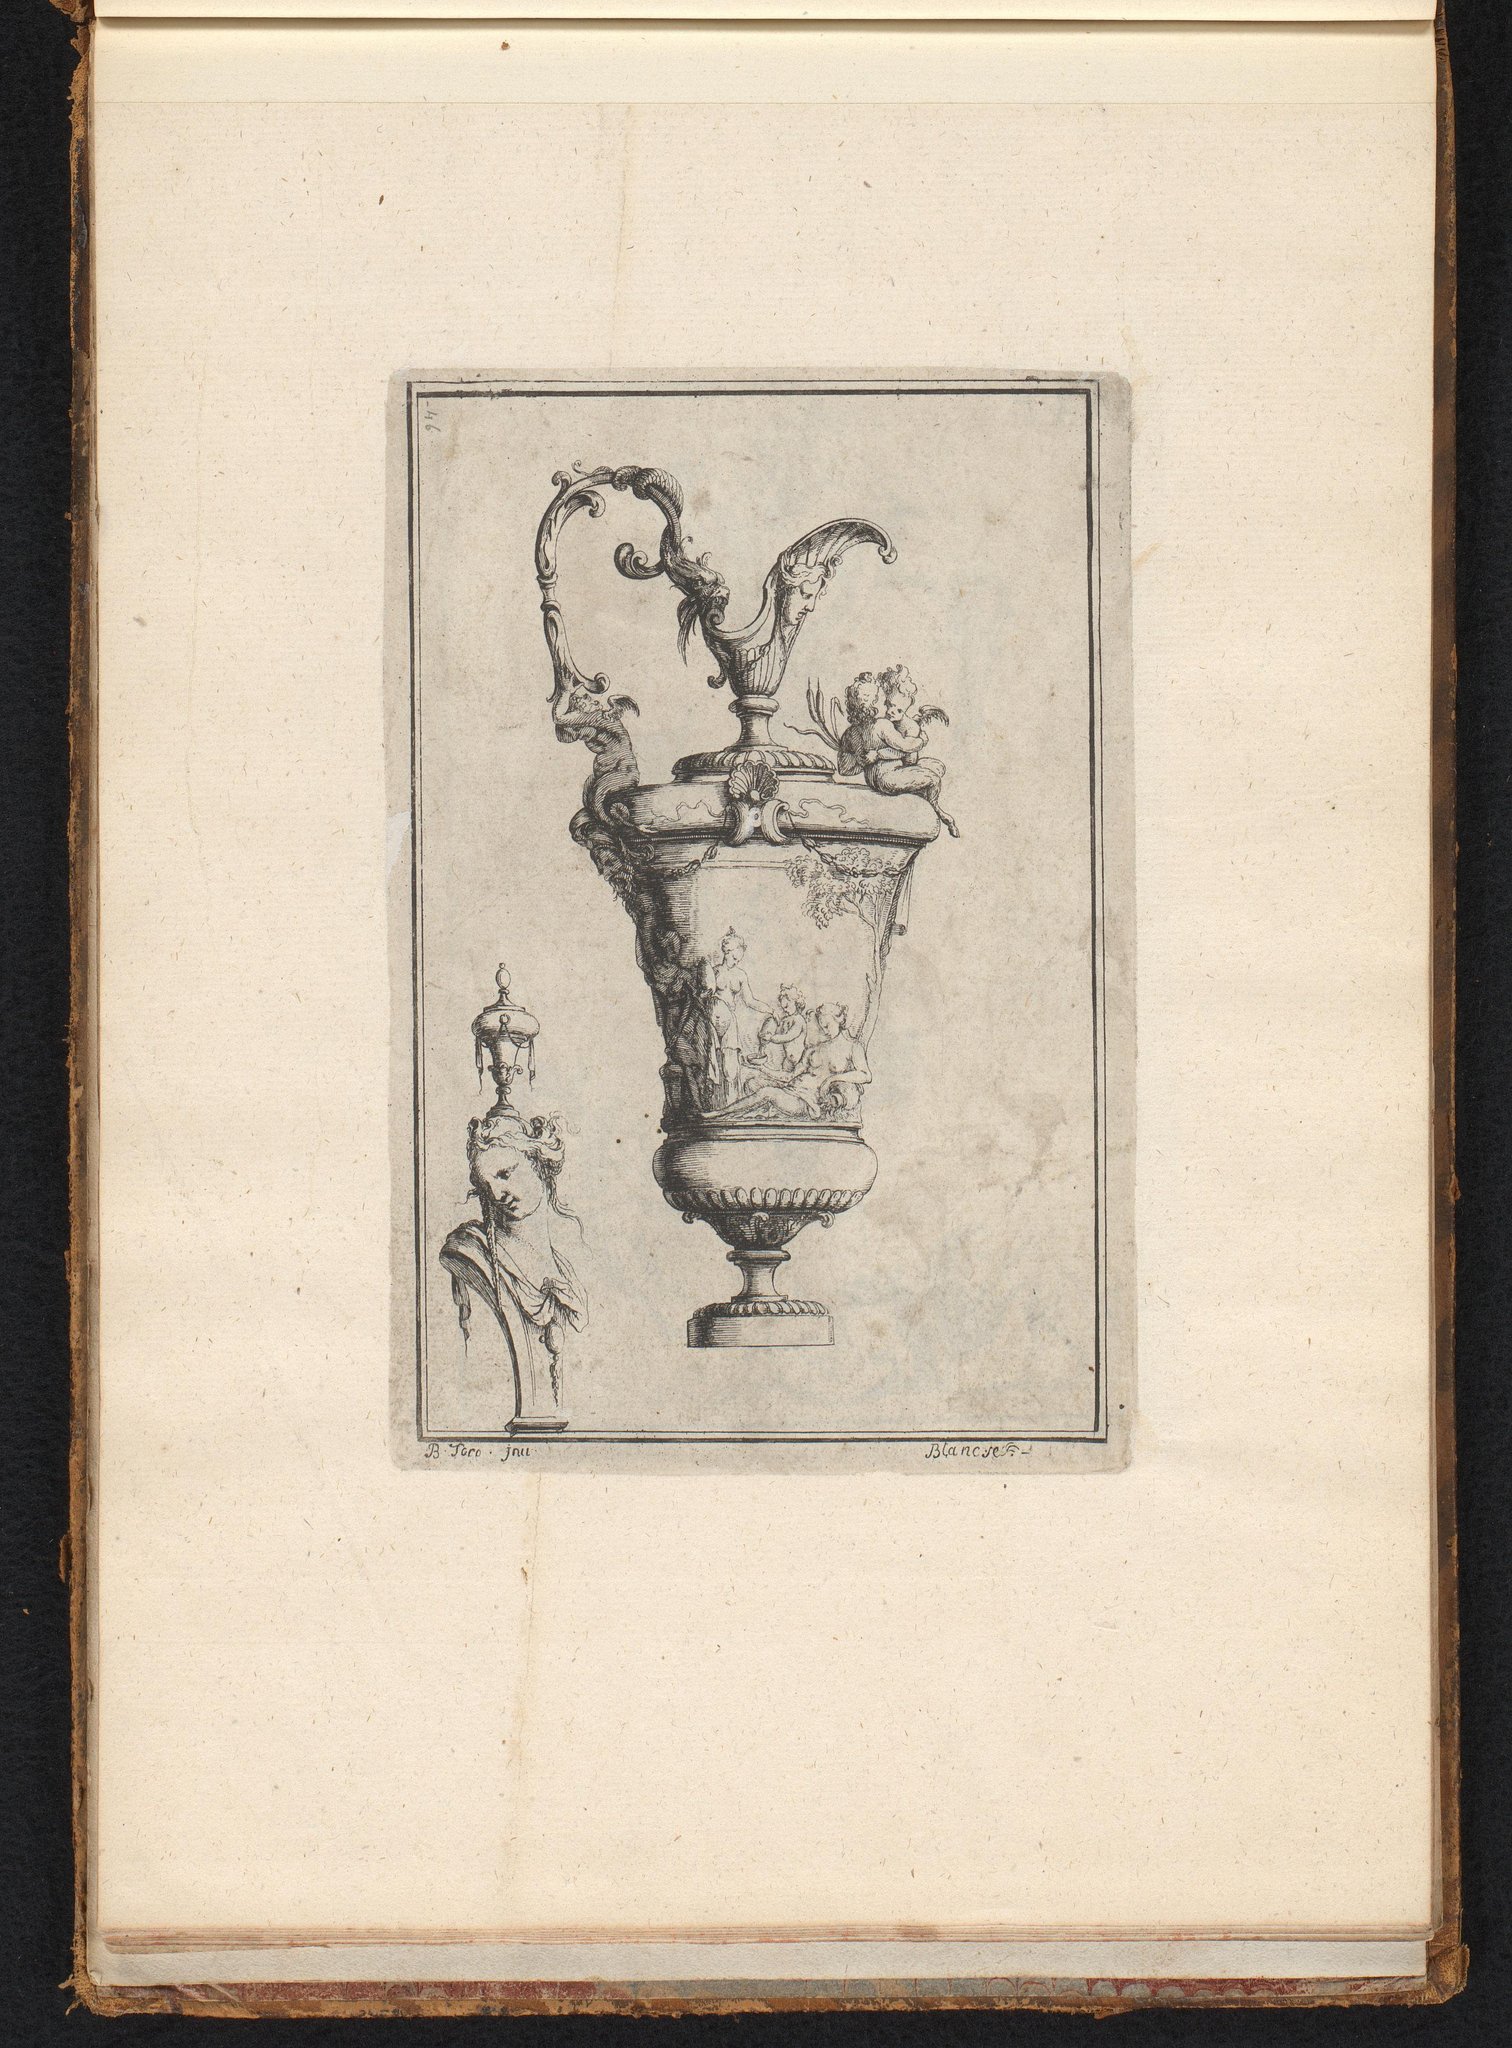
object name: print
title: Vases Nouveaus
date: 1682-1734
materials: paper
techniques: etching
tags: vase ~ ornament, nymphs (in general); 'ninfe in commune' (ripa), garden vase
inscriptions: annotation: ‘H3E’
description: Prent maakt deel uit van een serie van zes prenten.